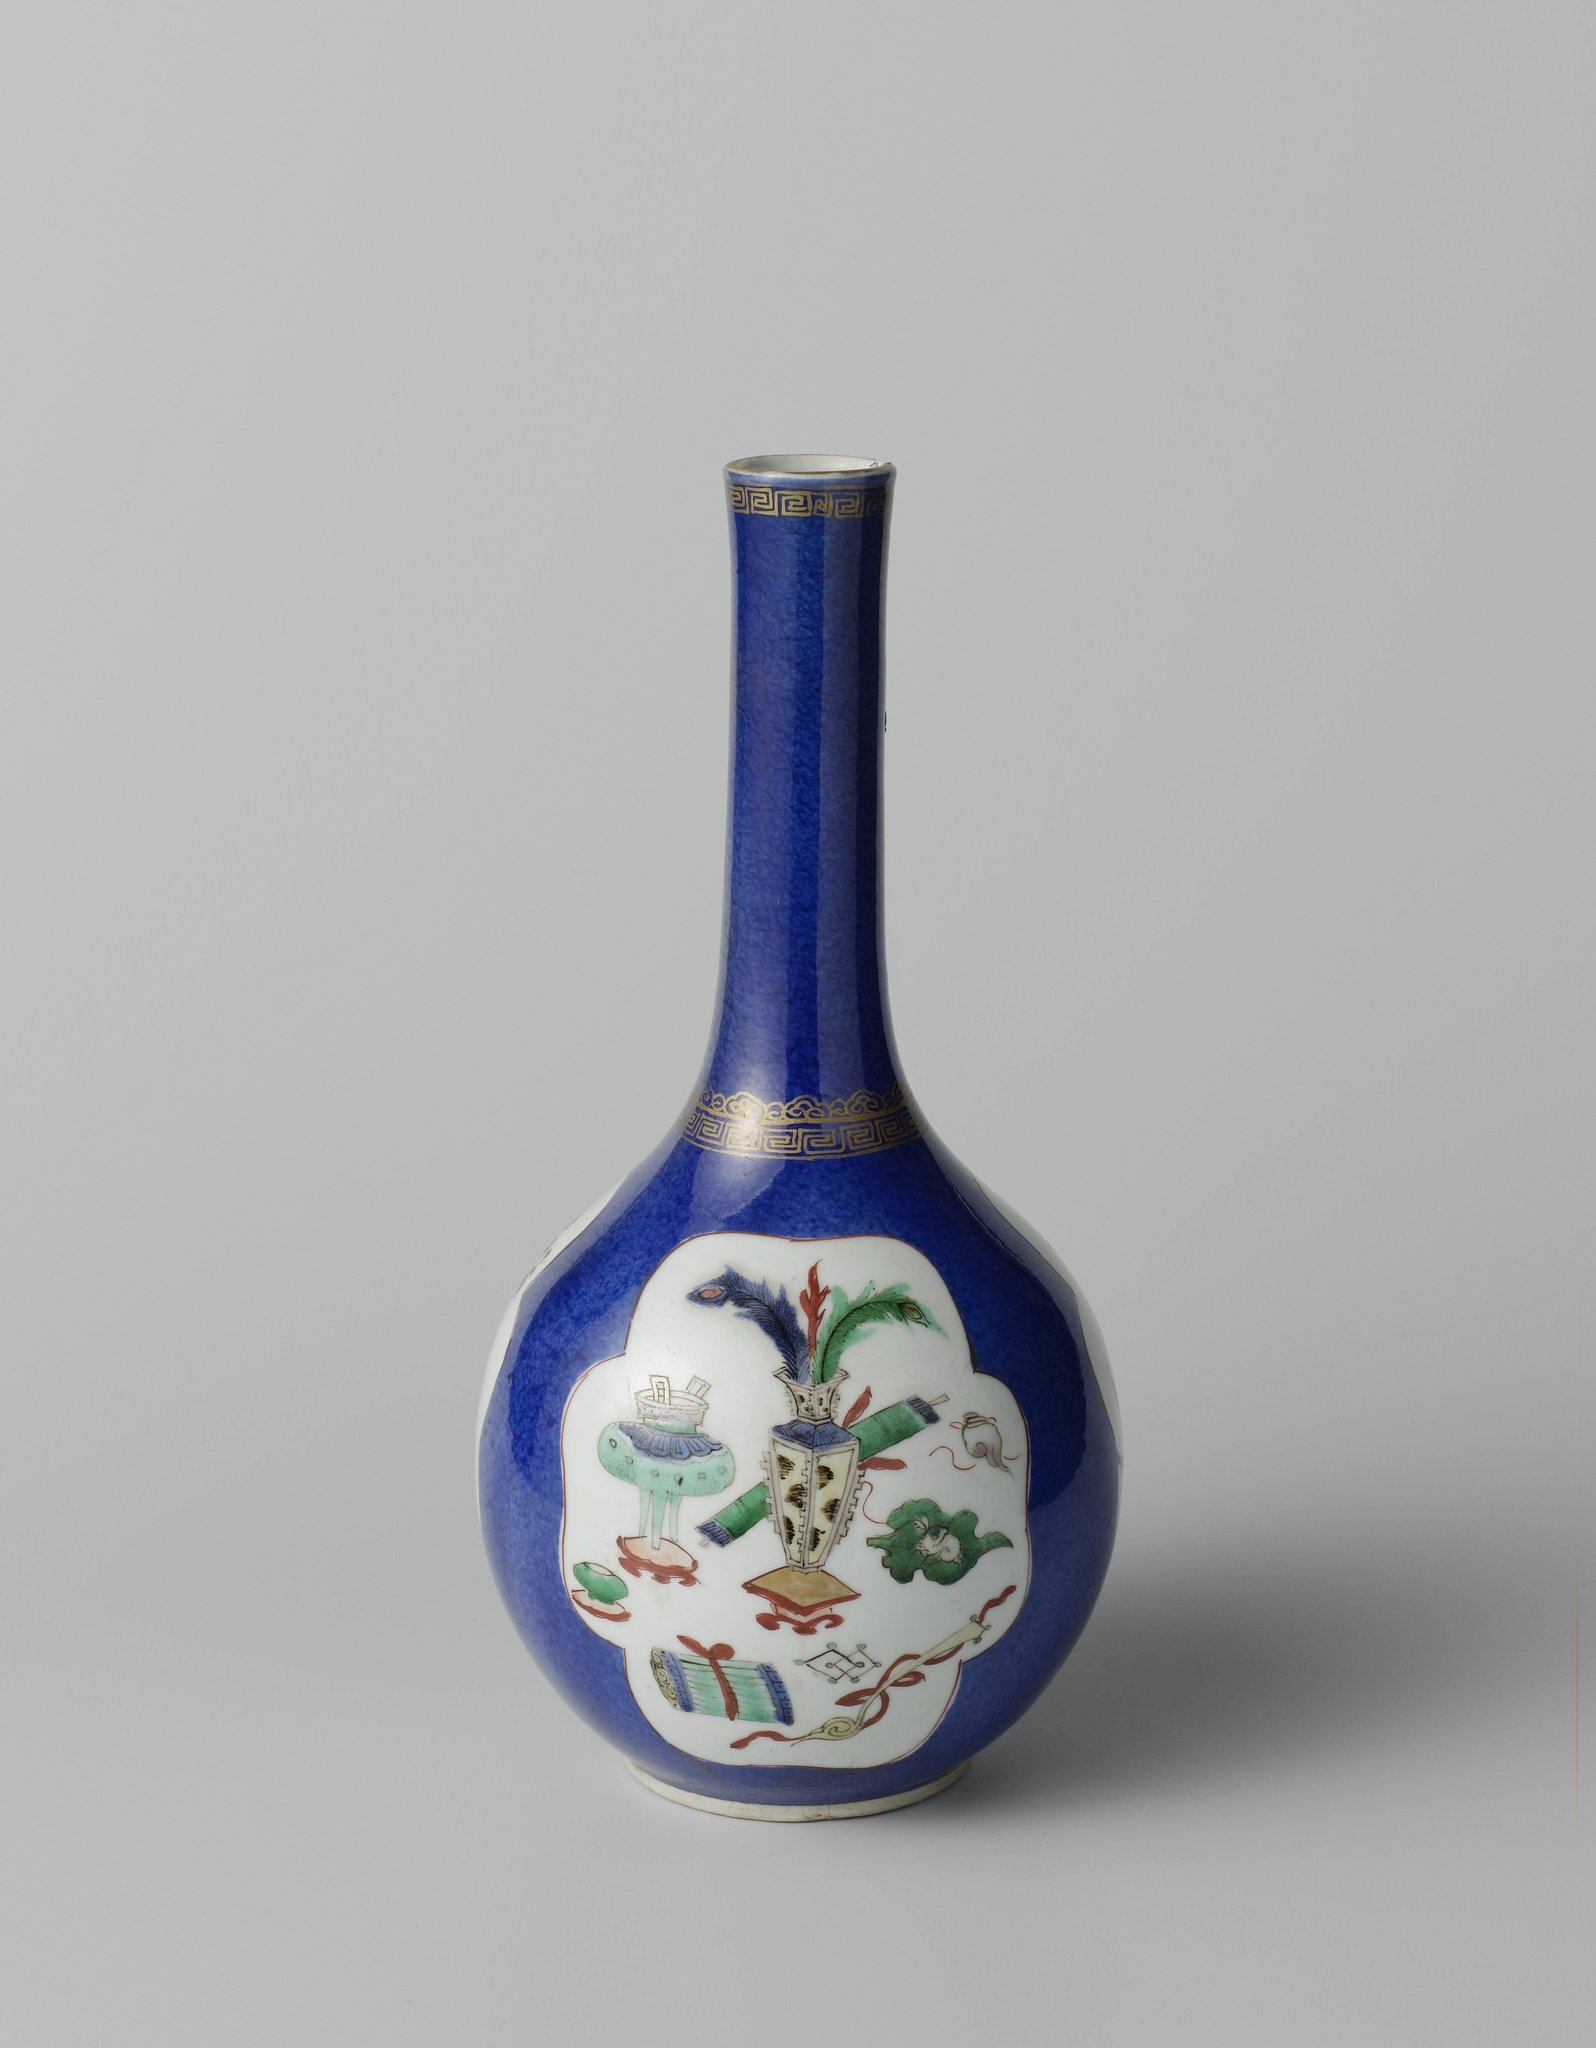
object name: vase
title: Pear-shaped bottle vase with powder blue, flower sprays and antiquities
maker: Anonymous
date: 1700-1724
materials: cobalt, glaze, gold, paint, porcelain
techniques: firing, gilding, turning, vitrification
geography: china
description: AK-NM-6368 Drie flessen • Bleu poudré porselein met verte • Onderdeel van Royers porseleincollectie • Mogelijk afkomstig van Susanna Louise Huygens • Gepubliceerd Jörg 2011, nr. 99. Door de iets diepere kleur blauw van het gesprenkelde blauw in de achtergrond en de met zorg geschilderde banden rond de hals lijken deze vazen verwant aan de fraaie dekselpot AK-NM-6362. Maar de velden zijn hier wel een stuk sneller en onzorgvuldiger geschilderd. Bovendien is hier blauw email gebruikt, een aanwijzing voor een iets latere datering. De kostbaarheden zijn een veel voorkomend motief op Kangxi-porselein, niet alleen bij het bleu poudré. Voor een toelichting, zie de opmerkingen bij AK-NM-6769. Waarschijnlijk kocht Royer deze vazen in 1786 uit de nalatenschap van zijn oudtante Susanna Louise Huygens (1714-1785). Huygens kocht toen veel porselein en dat zal ook hebben gegolden voor: ‘Drie flessen als vooren [hoog blauw met compartimenten waarin gecouleurde bloemen] met goude vergulde kransjes om de halzen.’ De omschrijving past nauwkeurig (gouden kransjes!) op deze drie vazen die nog steeds in de collectie Royer aanwezig zijn. Poudré was ook geliefd onder verzamelaars in de periode dat Chinees porselein opnieuw een verzamelonderwerp werd, vanaf het eind van de 19de eeuw. Een goed voorbeeld van een verzameling uit deze periode is die van Gustaaf Hamburger (1887-1977) en zijn vrouw Clara Gerzon (1907-2007). In hun collectie is in de omvangrijke groep poudré een paar identieke flessen te vinden (Bosmans 2011, nr. 40, p. 74). Bronnen : Sarah Bosmans, ‘La collection Chinoise Hamburger : une collection caratéristique du XIXe siècle’, in : La donation Clare van Beusekom-Hamburger. Faïences et porcelaines des XVIe-XVIIe siècles (tent.cat. Ariana) Genève, 2010, pp. 52-109.